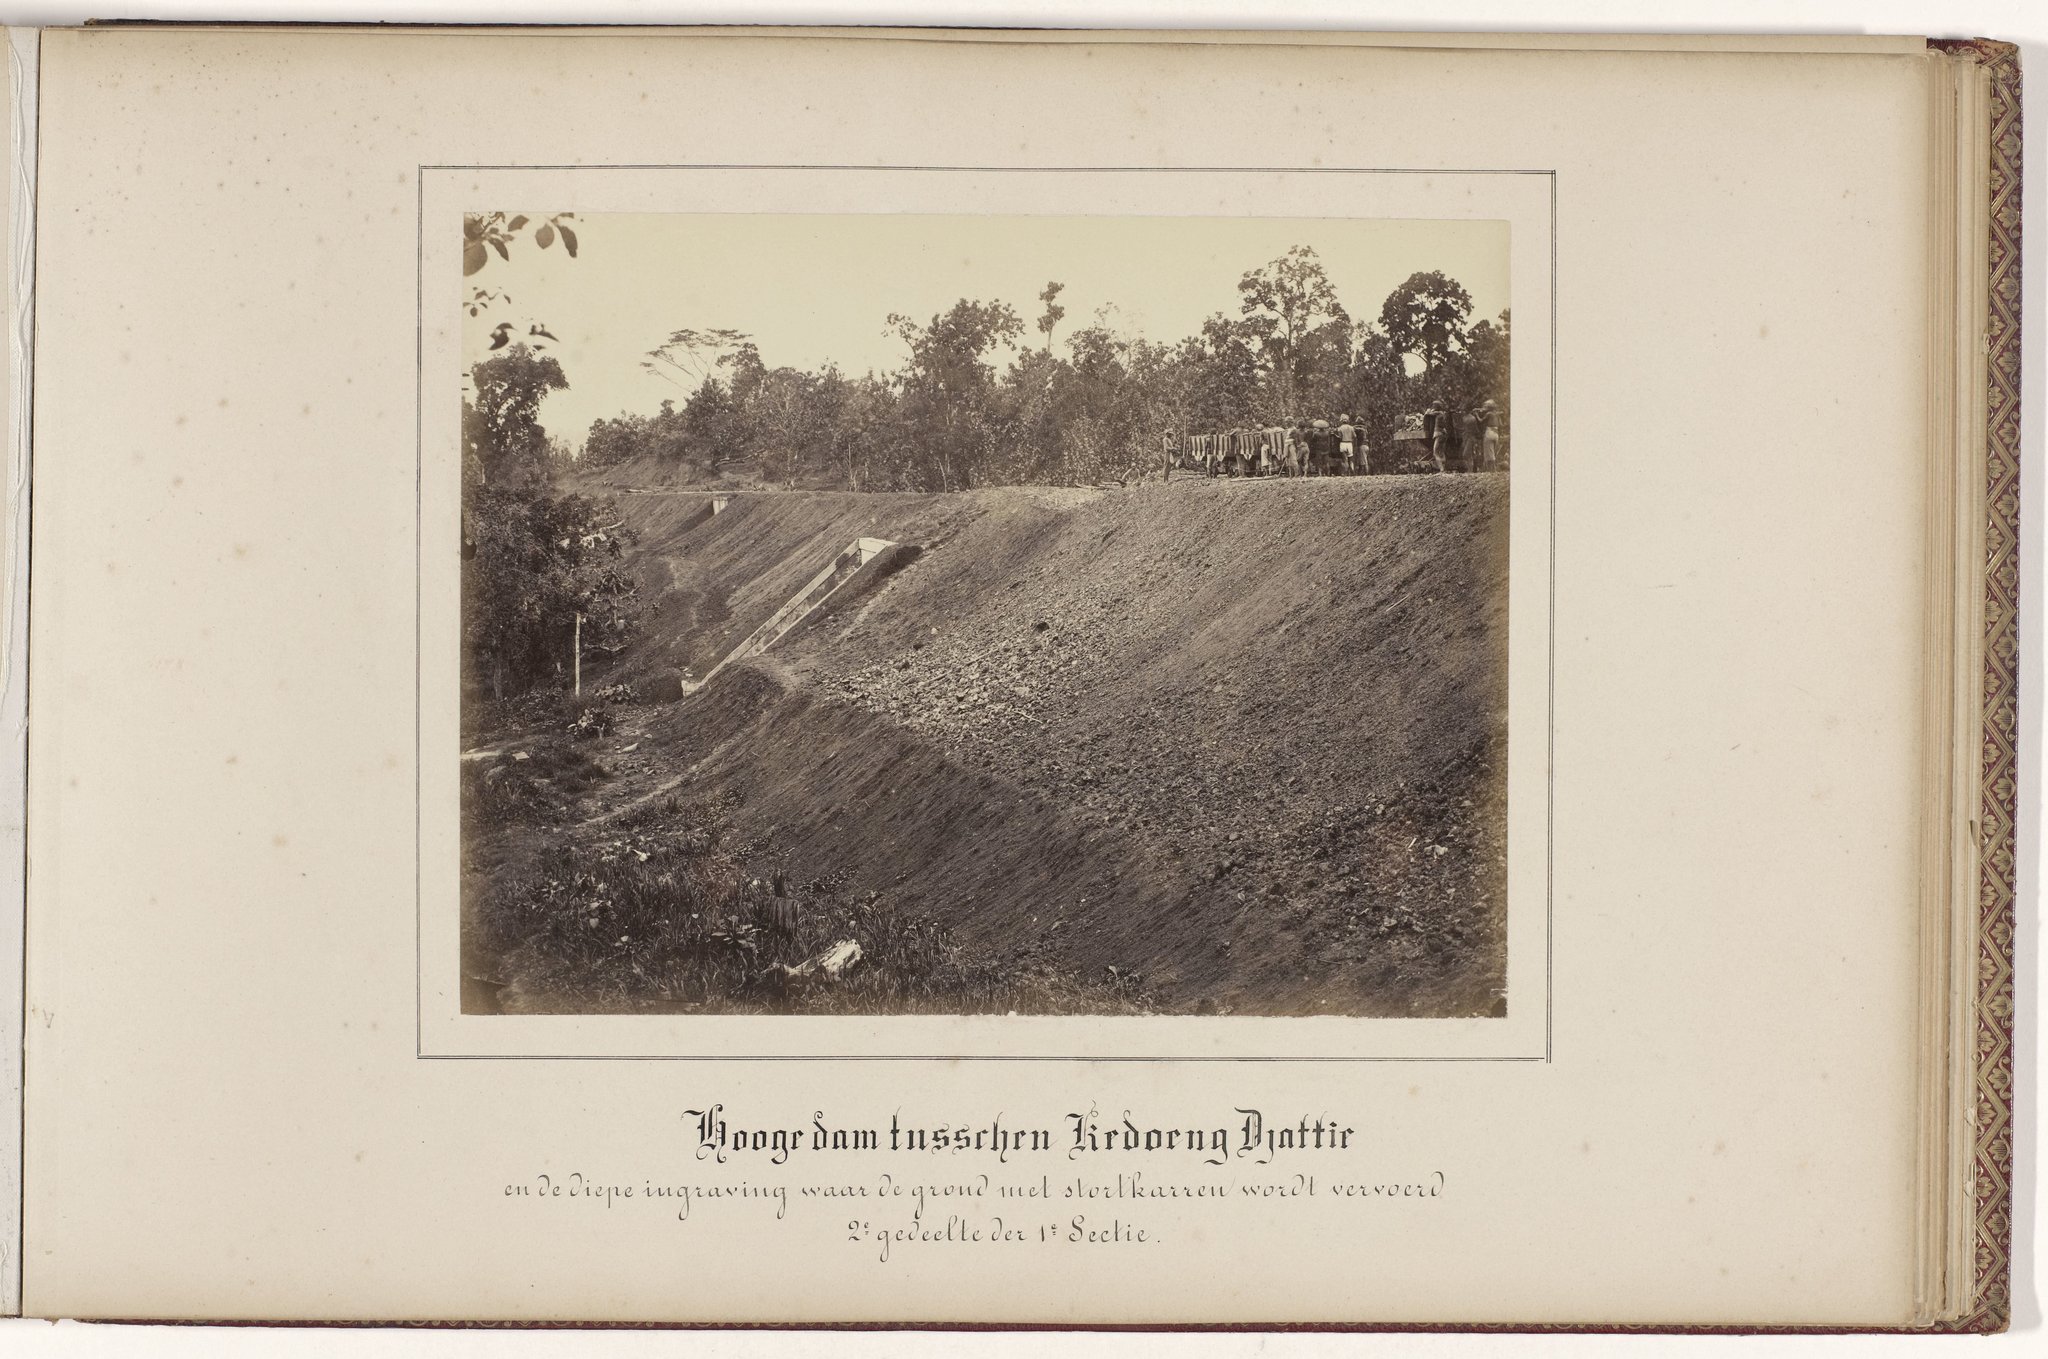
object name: album leaf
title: Hooge dam tusschen Kedoeng Djattie / en de diepe ingraving waar de grond met stortkarren wordt vervoerd / 2e gedeelte der 1e Sectie.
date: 1865-1867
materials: cardboard, photographic support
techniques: albumen print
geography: java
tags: colonial system, railway-traffic, building-site, java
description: Storten van aarde met stortkarren op de verhoogde spoordam bij Kedoeng Djattie. Albumblad met opgeplakte foto, onderdeel van het fotoalbum over de aanleg van de spoorlijn Semarang - Kedoeng Djattie (Kedungjati) op Java in 1865.